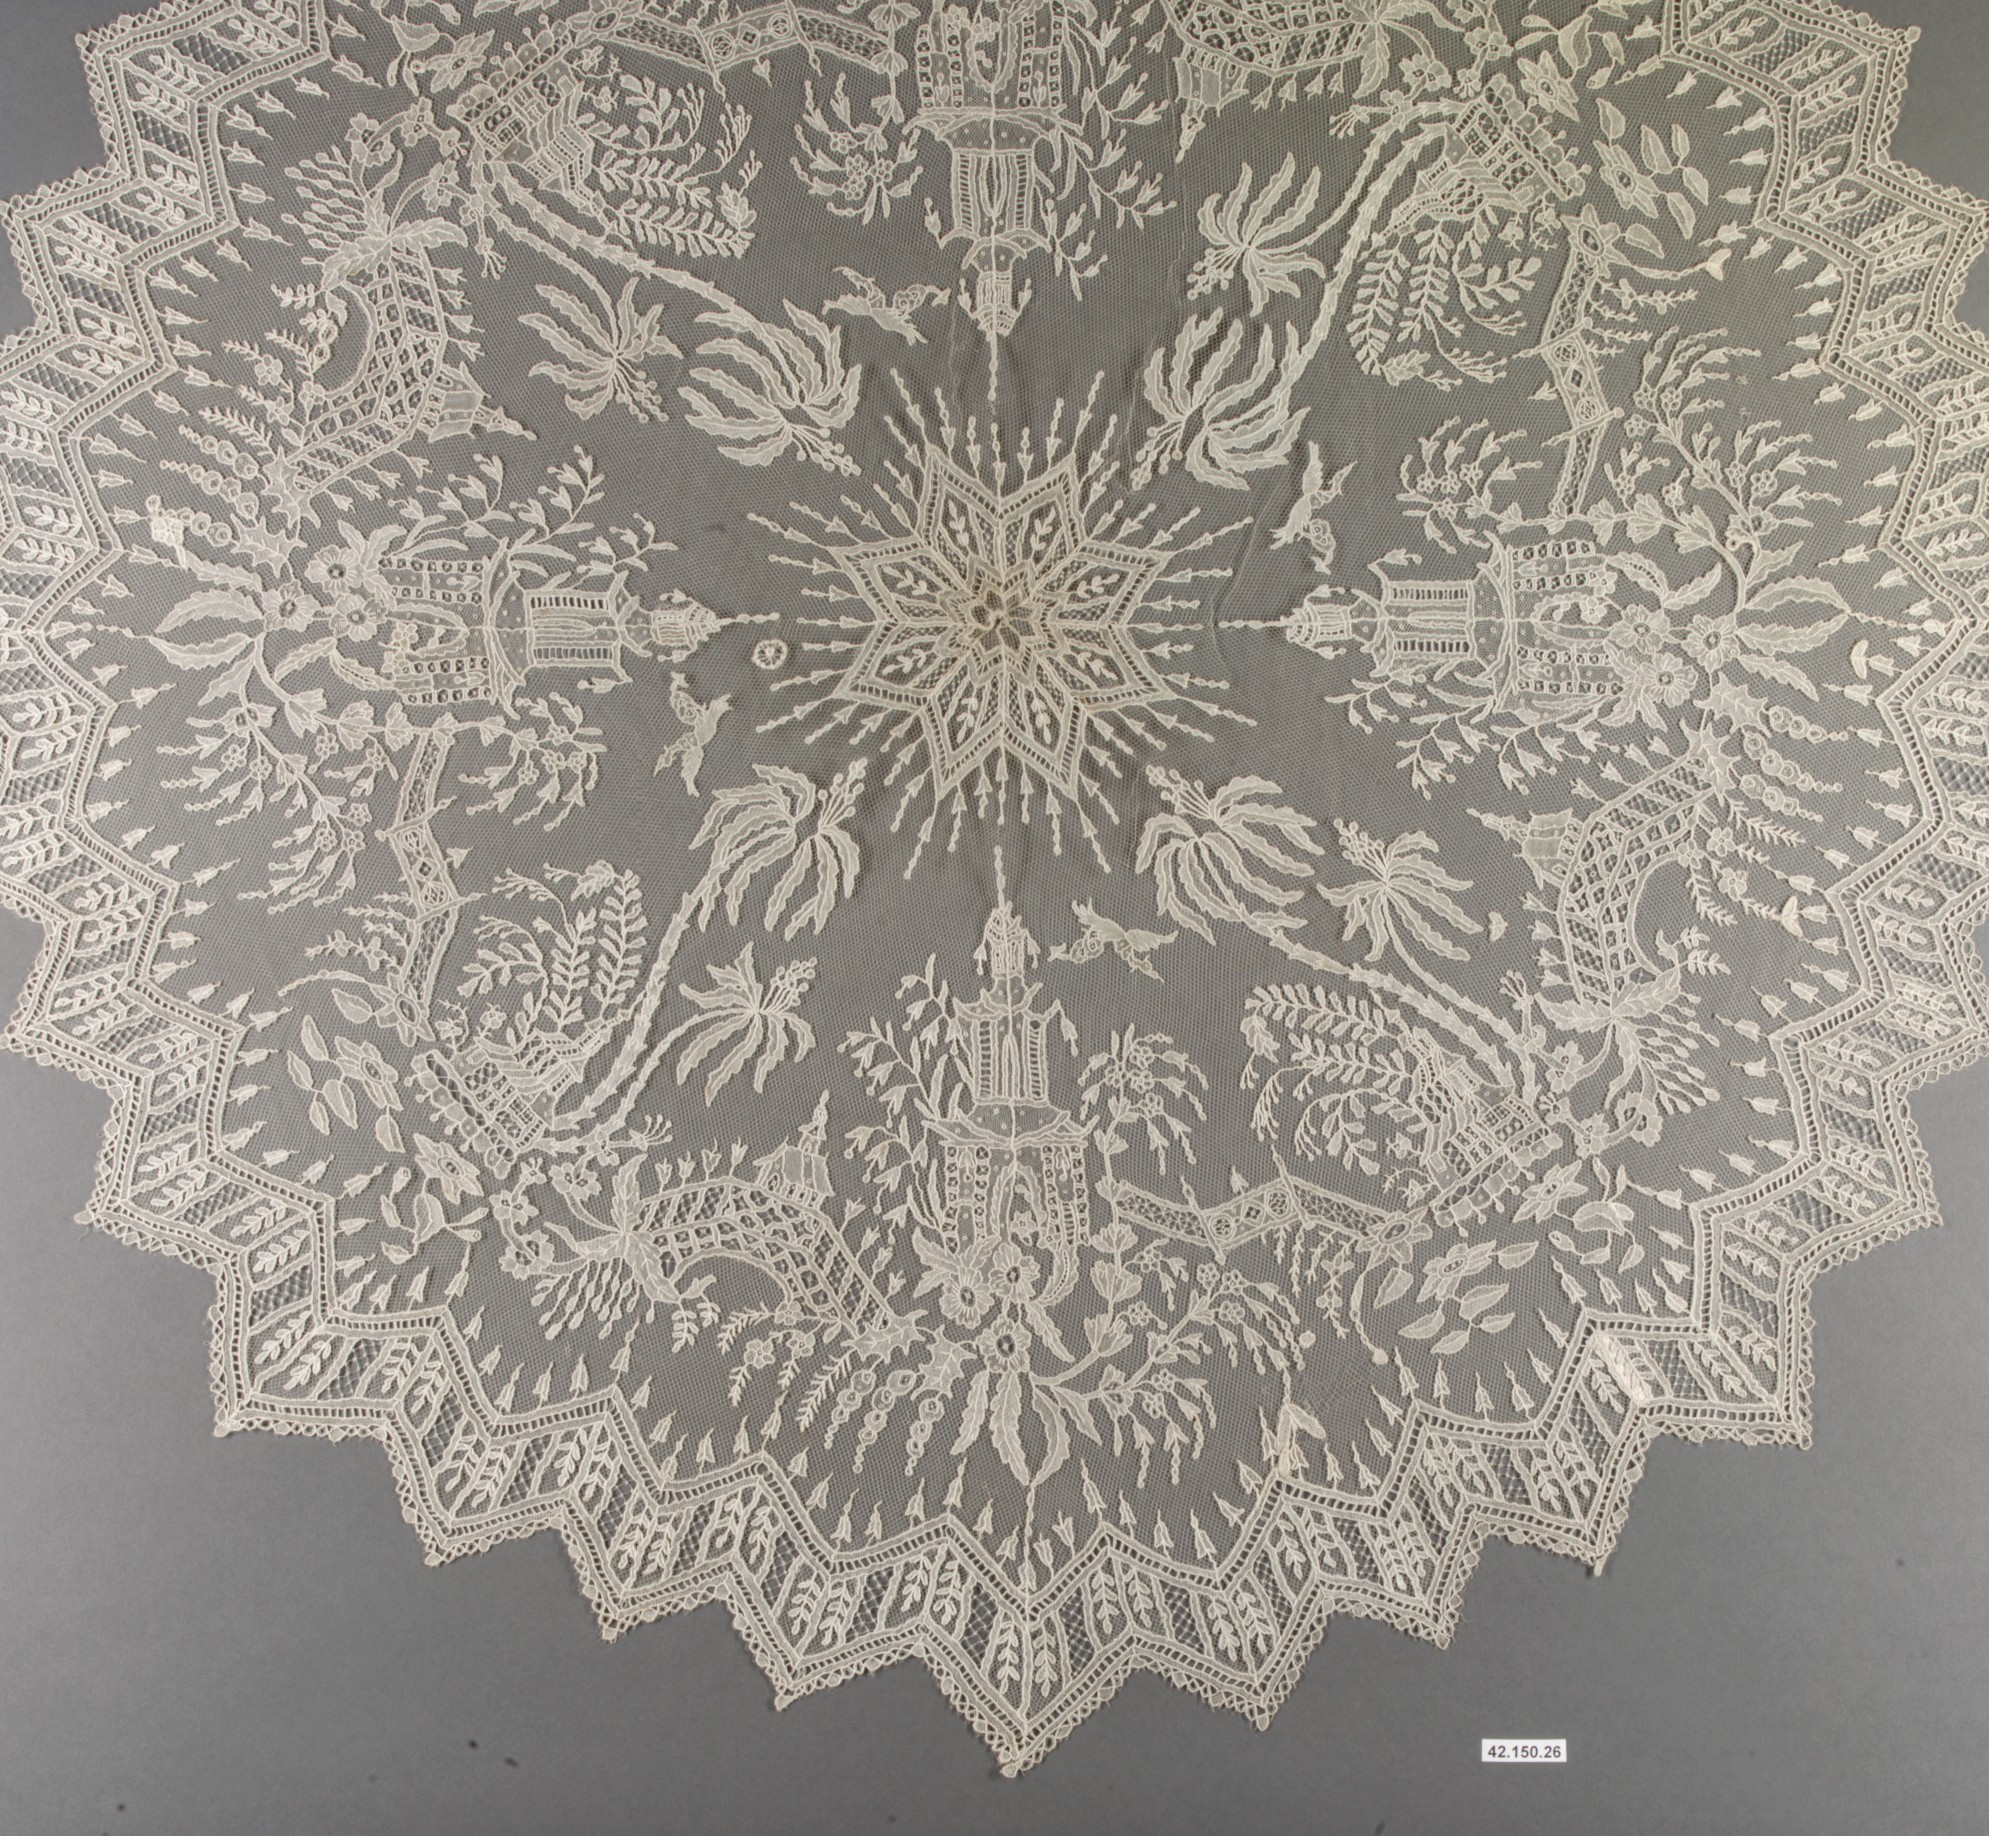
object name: parasol top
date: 1801-1900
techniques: lace